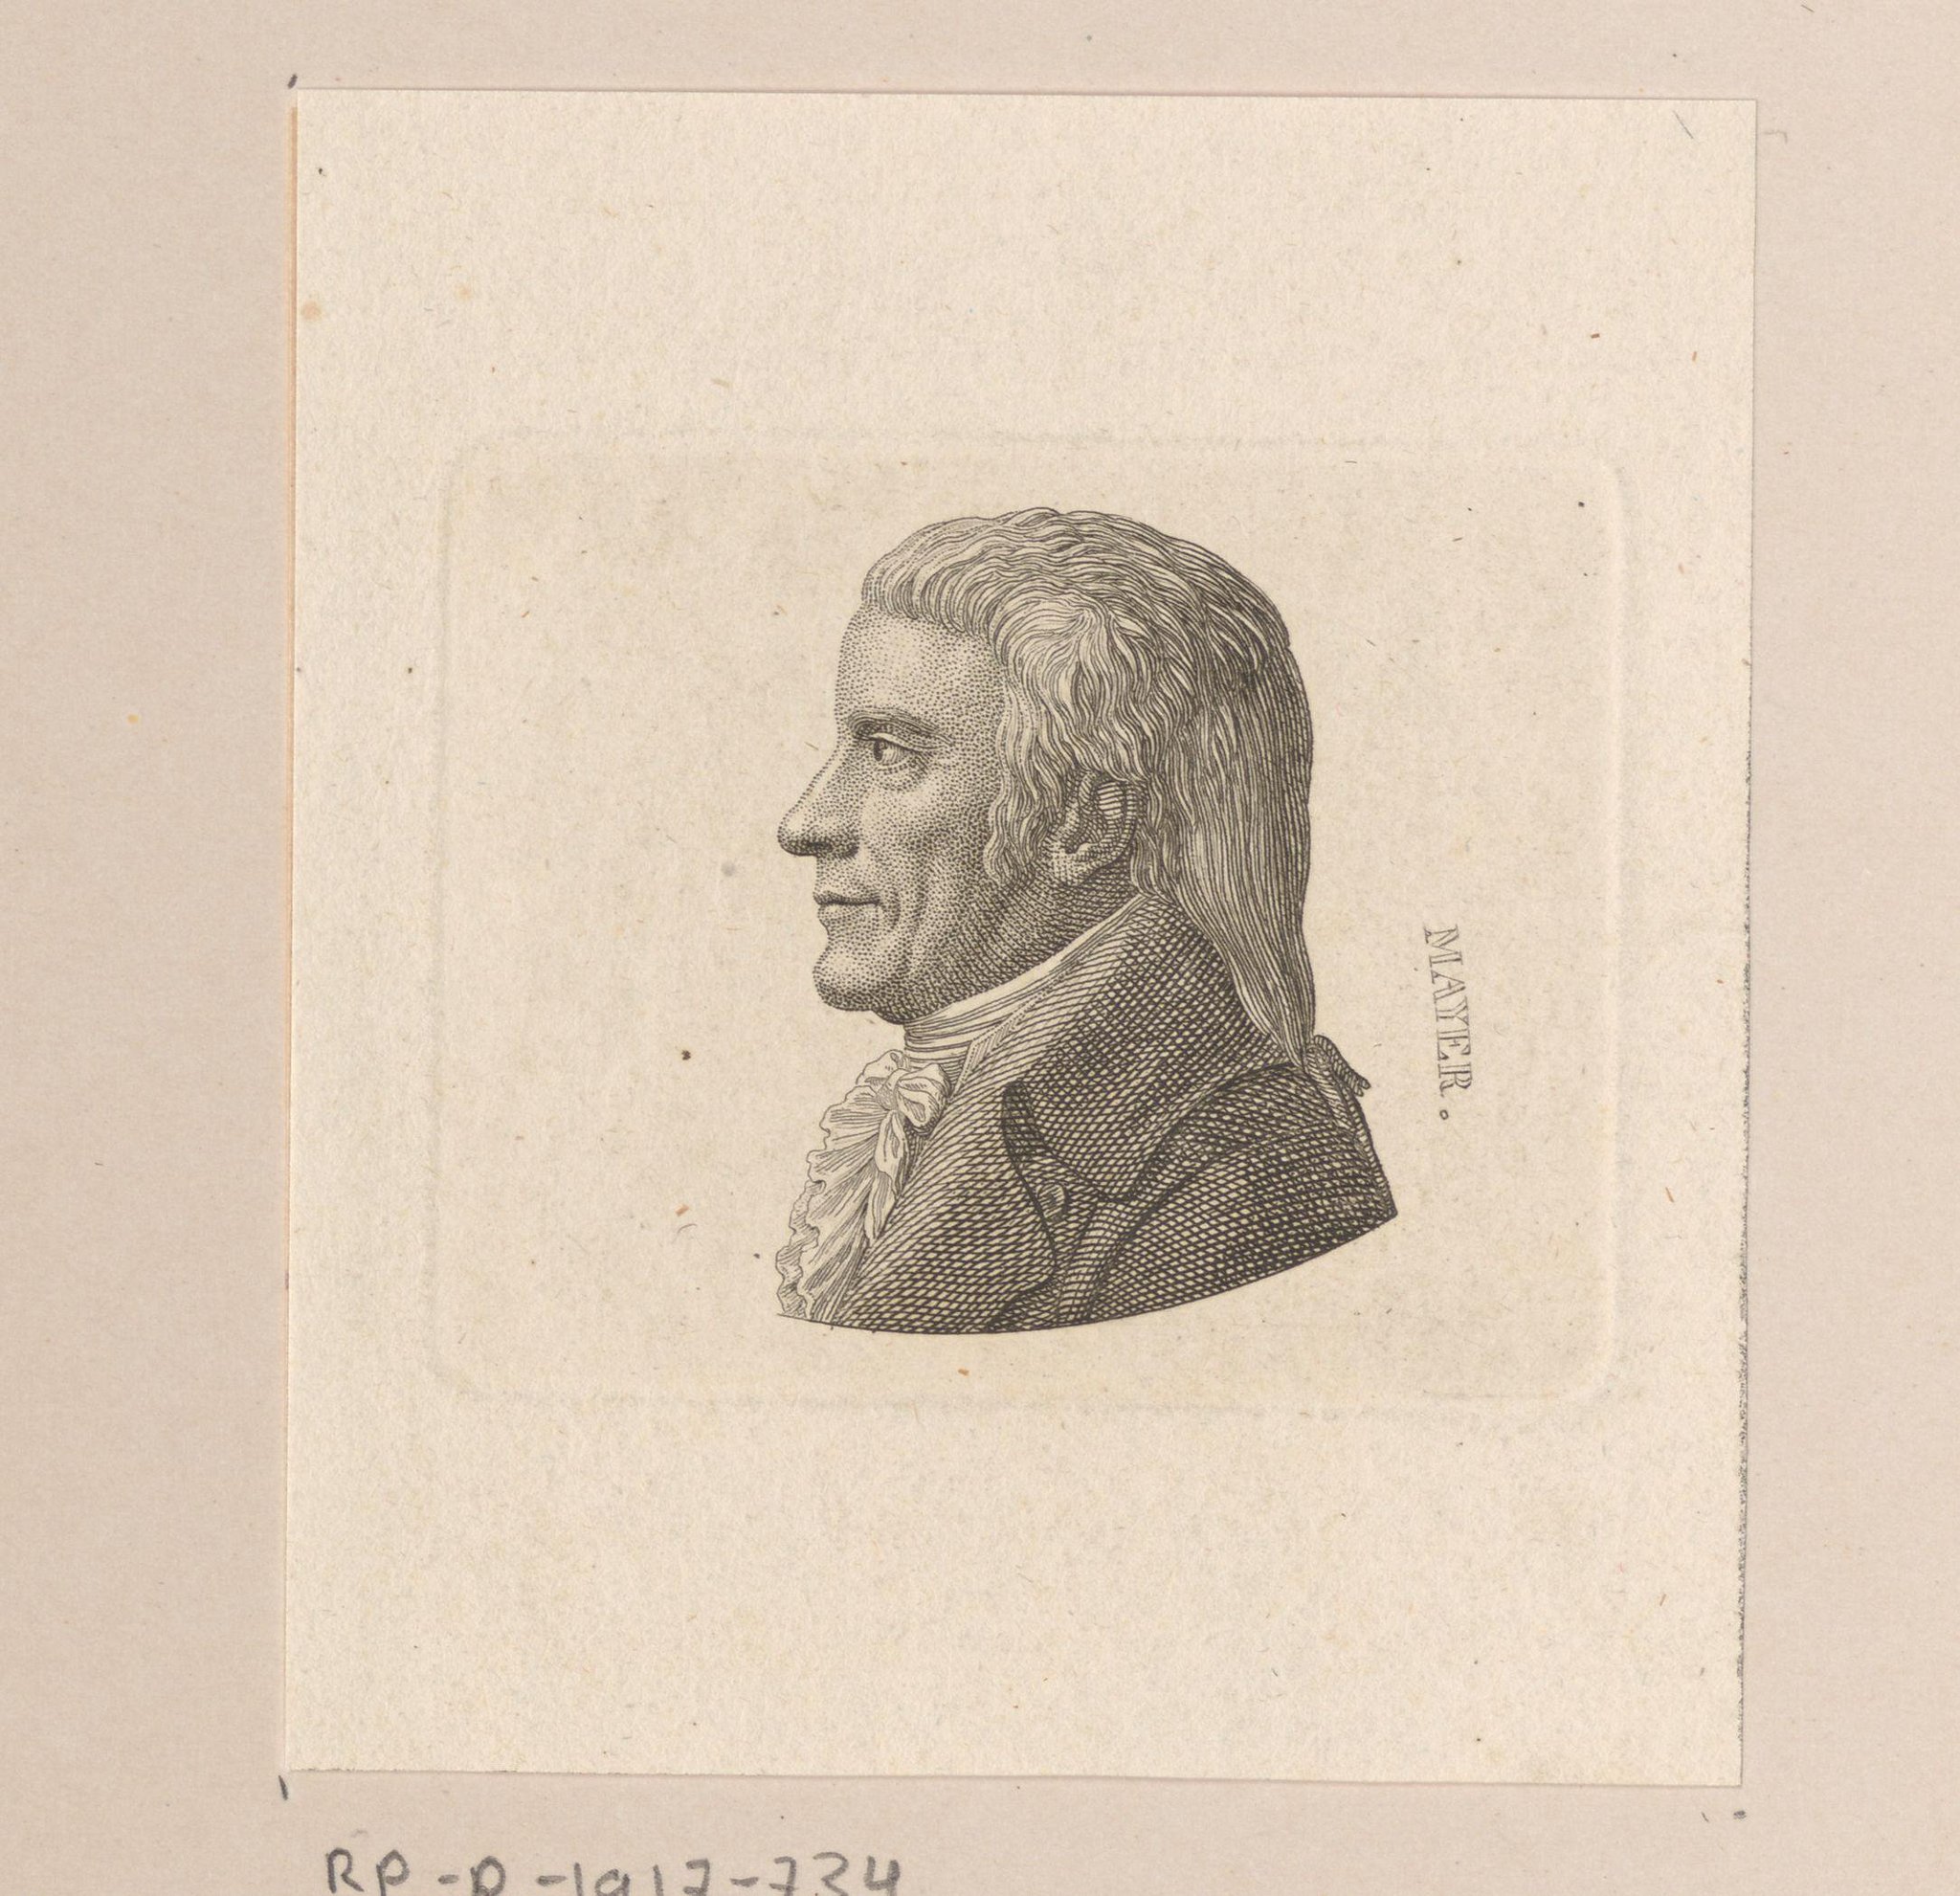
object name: print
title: Portret van Johann Tobias Mayer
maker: ernst ludwig riepenhausen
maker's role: print maker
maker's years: 1765-1840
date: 1780-1840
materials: paper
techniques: etching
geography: germany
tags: physicist, physics (+ portrait of scholar, scientist), historical persons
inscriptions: inscription: ‘Riepenhausen sc’, collector's mark: Lugt 2228